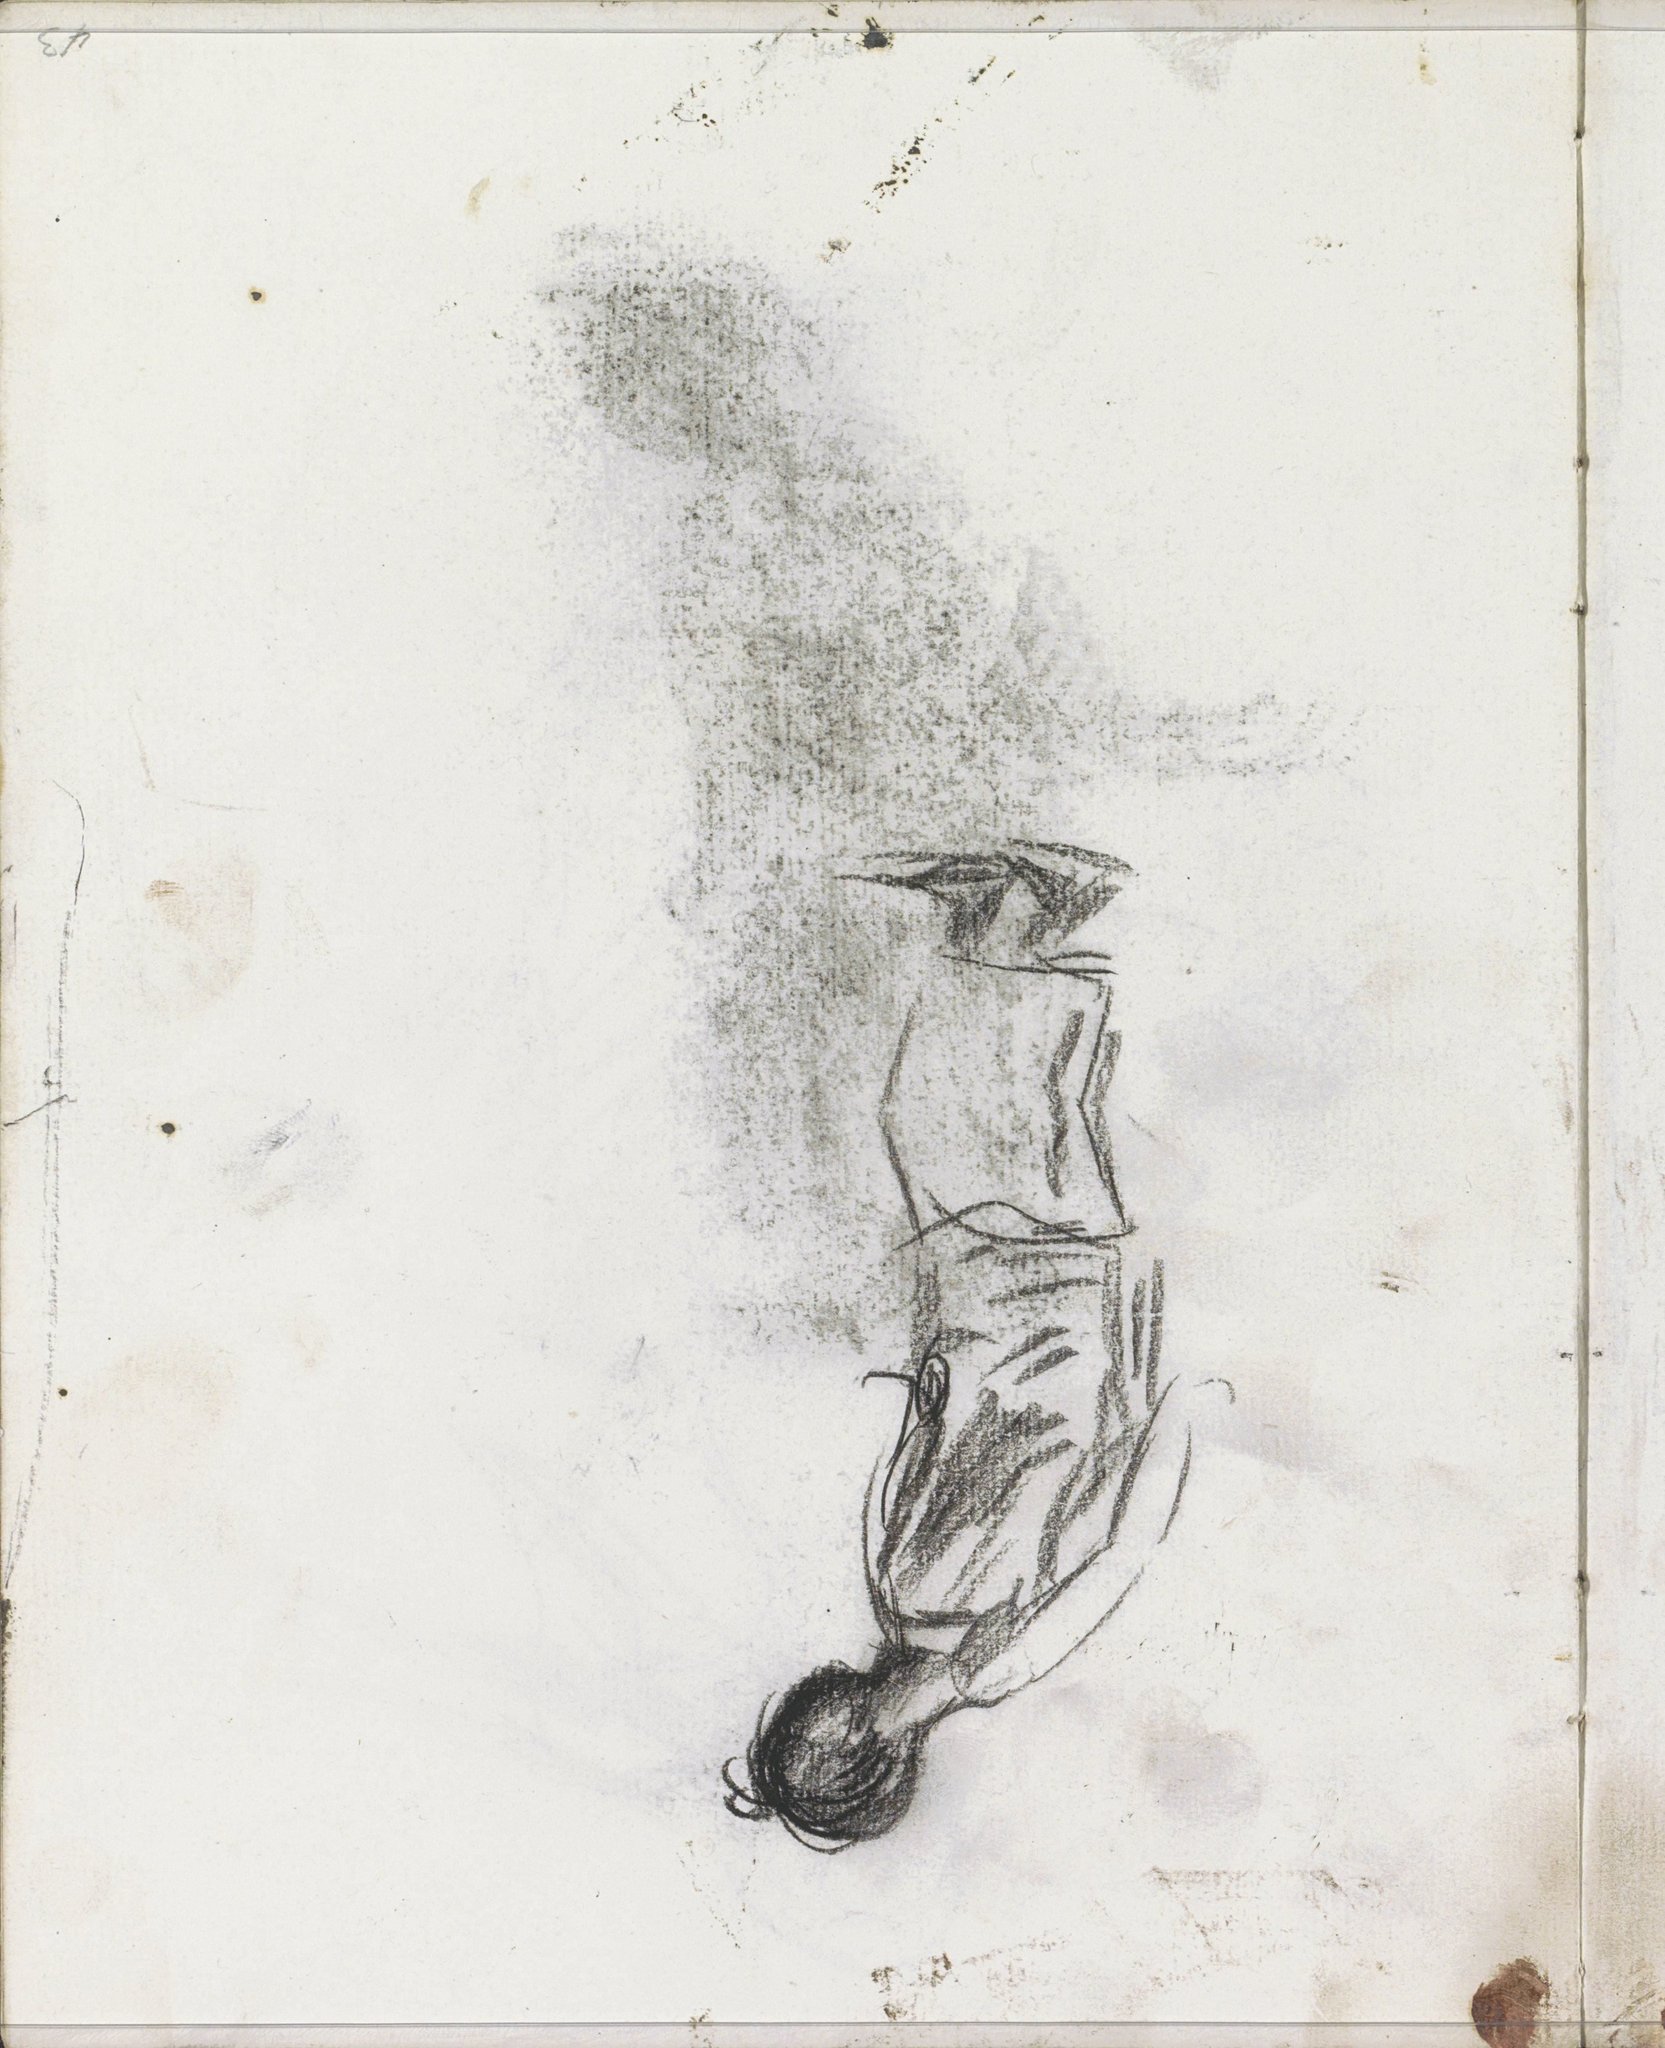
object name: sketchbook leaf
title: Vooroverbuigende figuur, mogelijk een danser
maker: isaac israels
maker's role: draughtsman, painter, print maker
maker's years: 1865-1934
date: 1875-1934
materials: chalk, paper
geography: the hague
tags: leaning forward, dancing, africans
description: Waarschijnlijk een Afrikaanse vrouw. Blad 8 verso uit schetsboek XIII met 25 bladen.